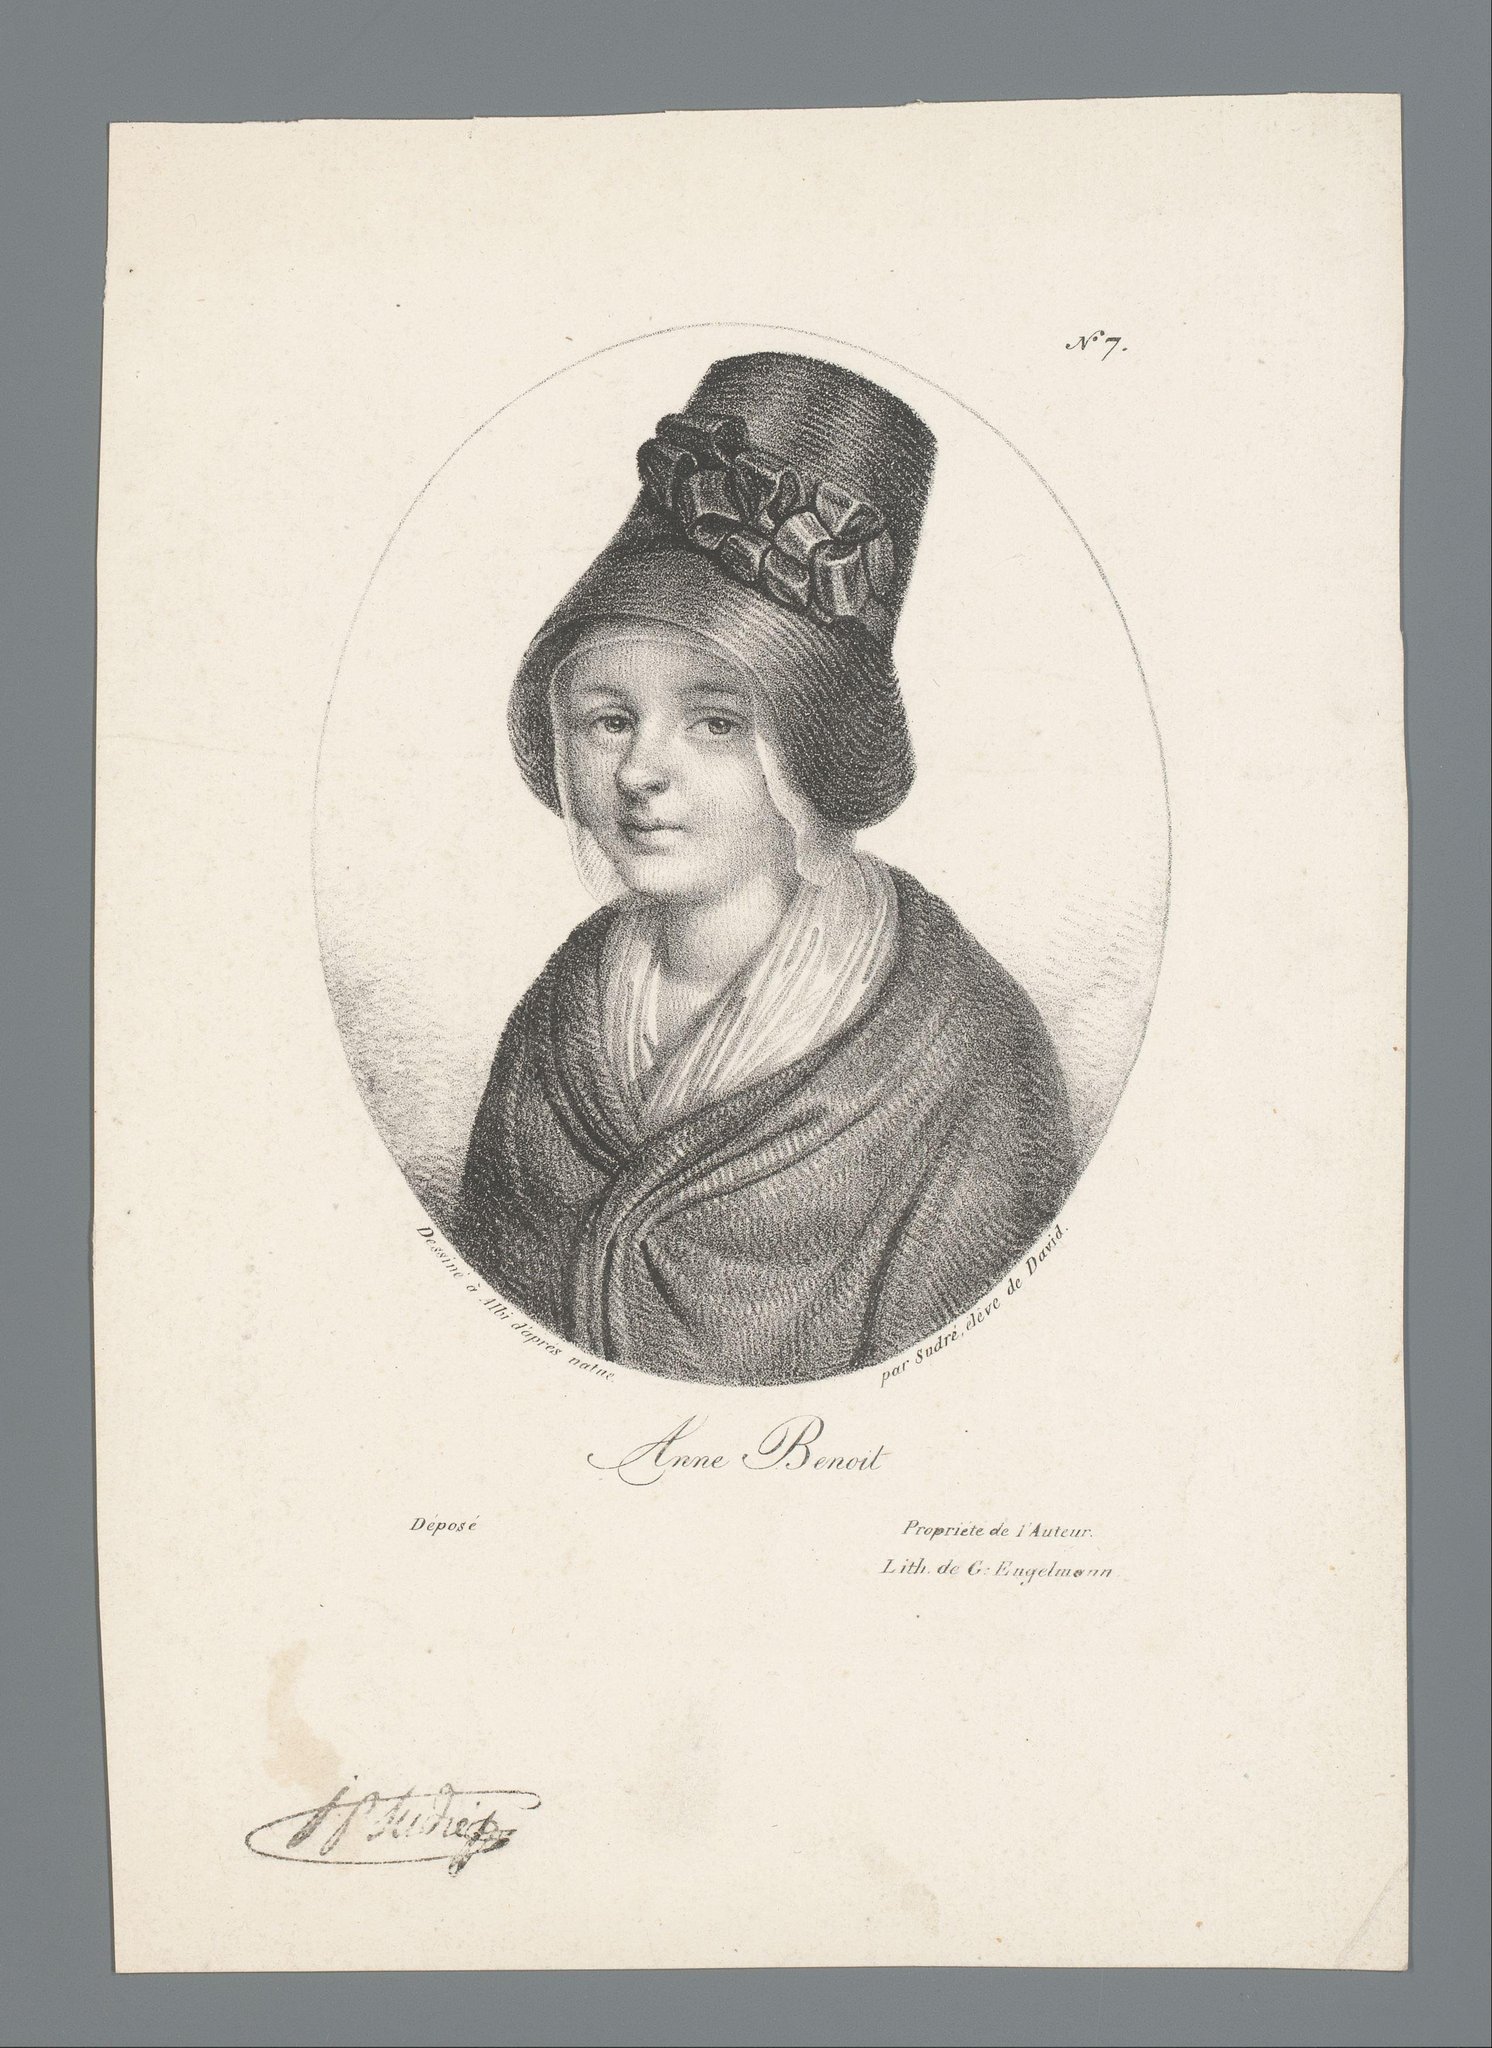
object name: print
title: Portret van Anne Benoit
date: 1818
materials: paper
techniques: lithograph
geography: paris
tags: historical persons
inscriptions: collector's mark: Lugt 2228, stamp: Lugt 2325b